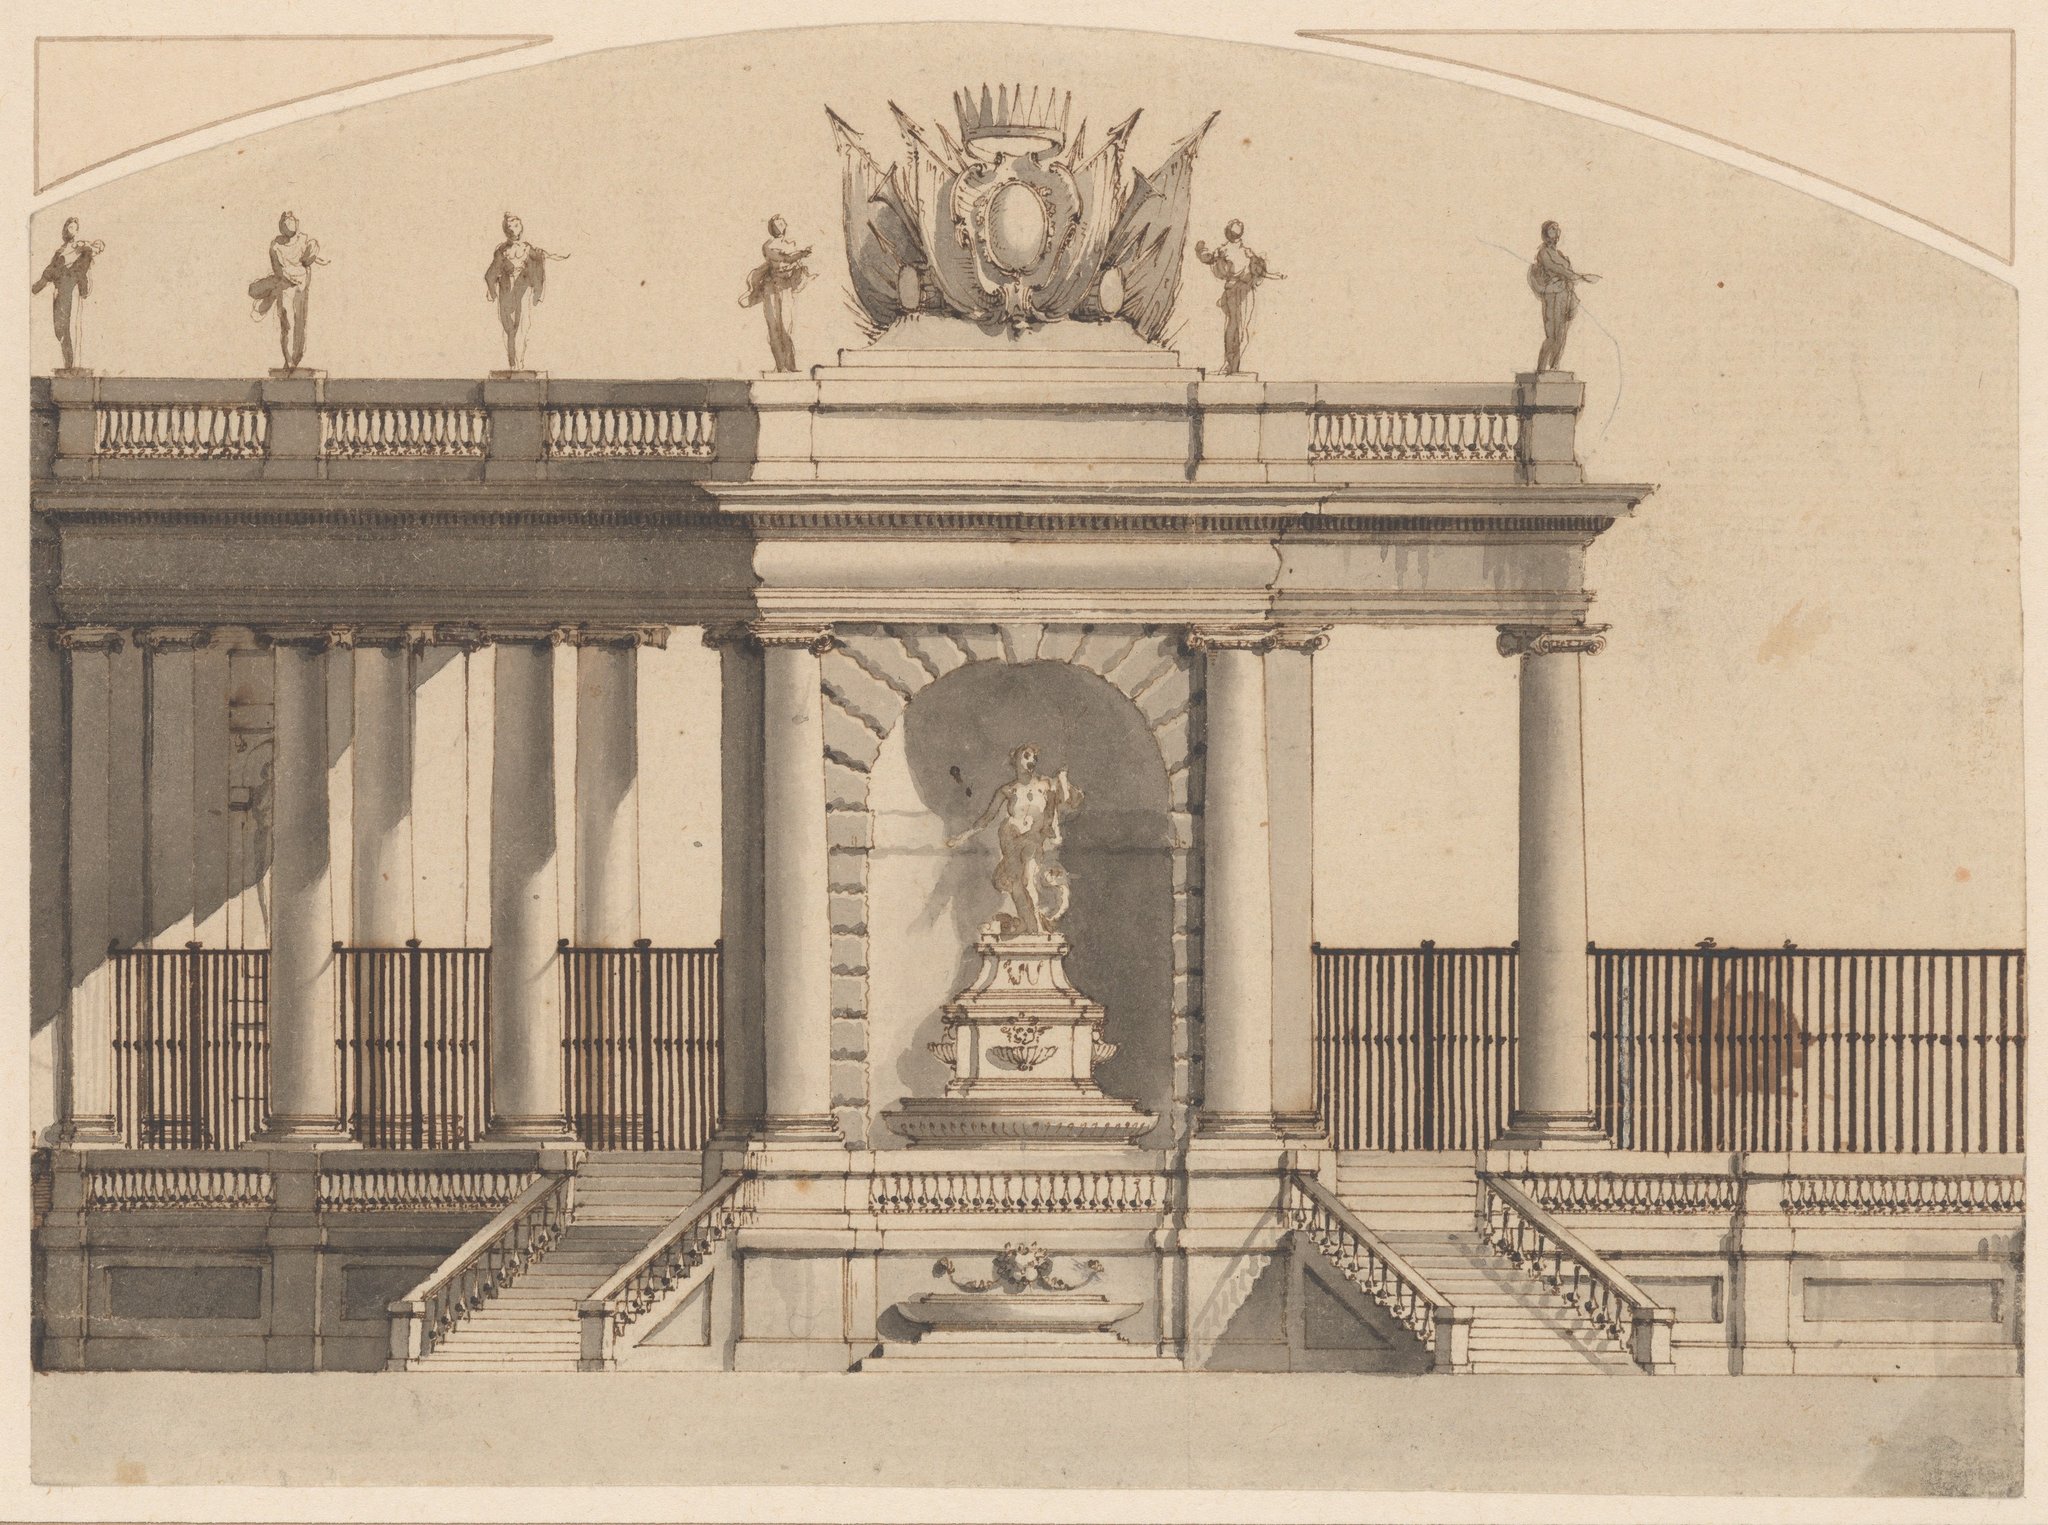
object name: drawing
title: Colonnade and Fountain with a Crowned Armorial Shield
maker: anonymous, italian, second half of the 18th century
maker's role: artist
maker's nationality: italian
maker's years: 1750-1800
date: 1750-1800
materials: ink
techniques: pen, wash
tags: architecture,columns,fountains